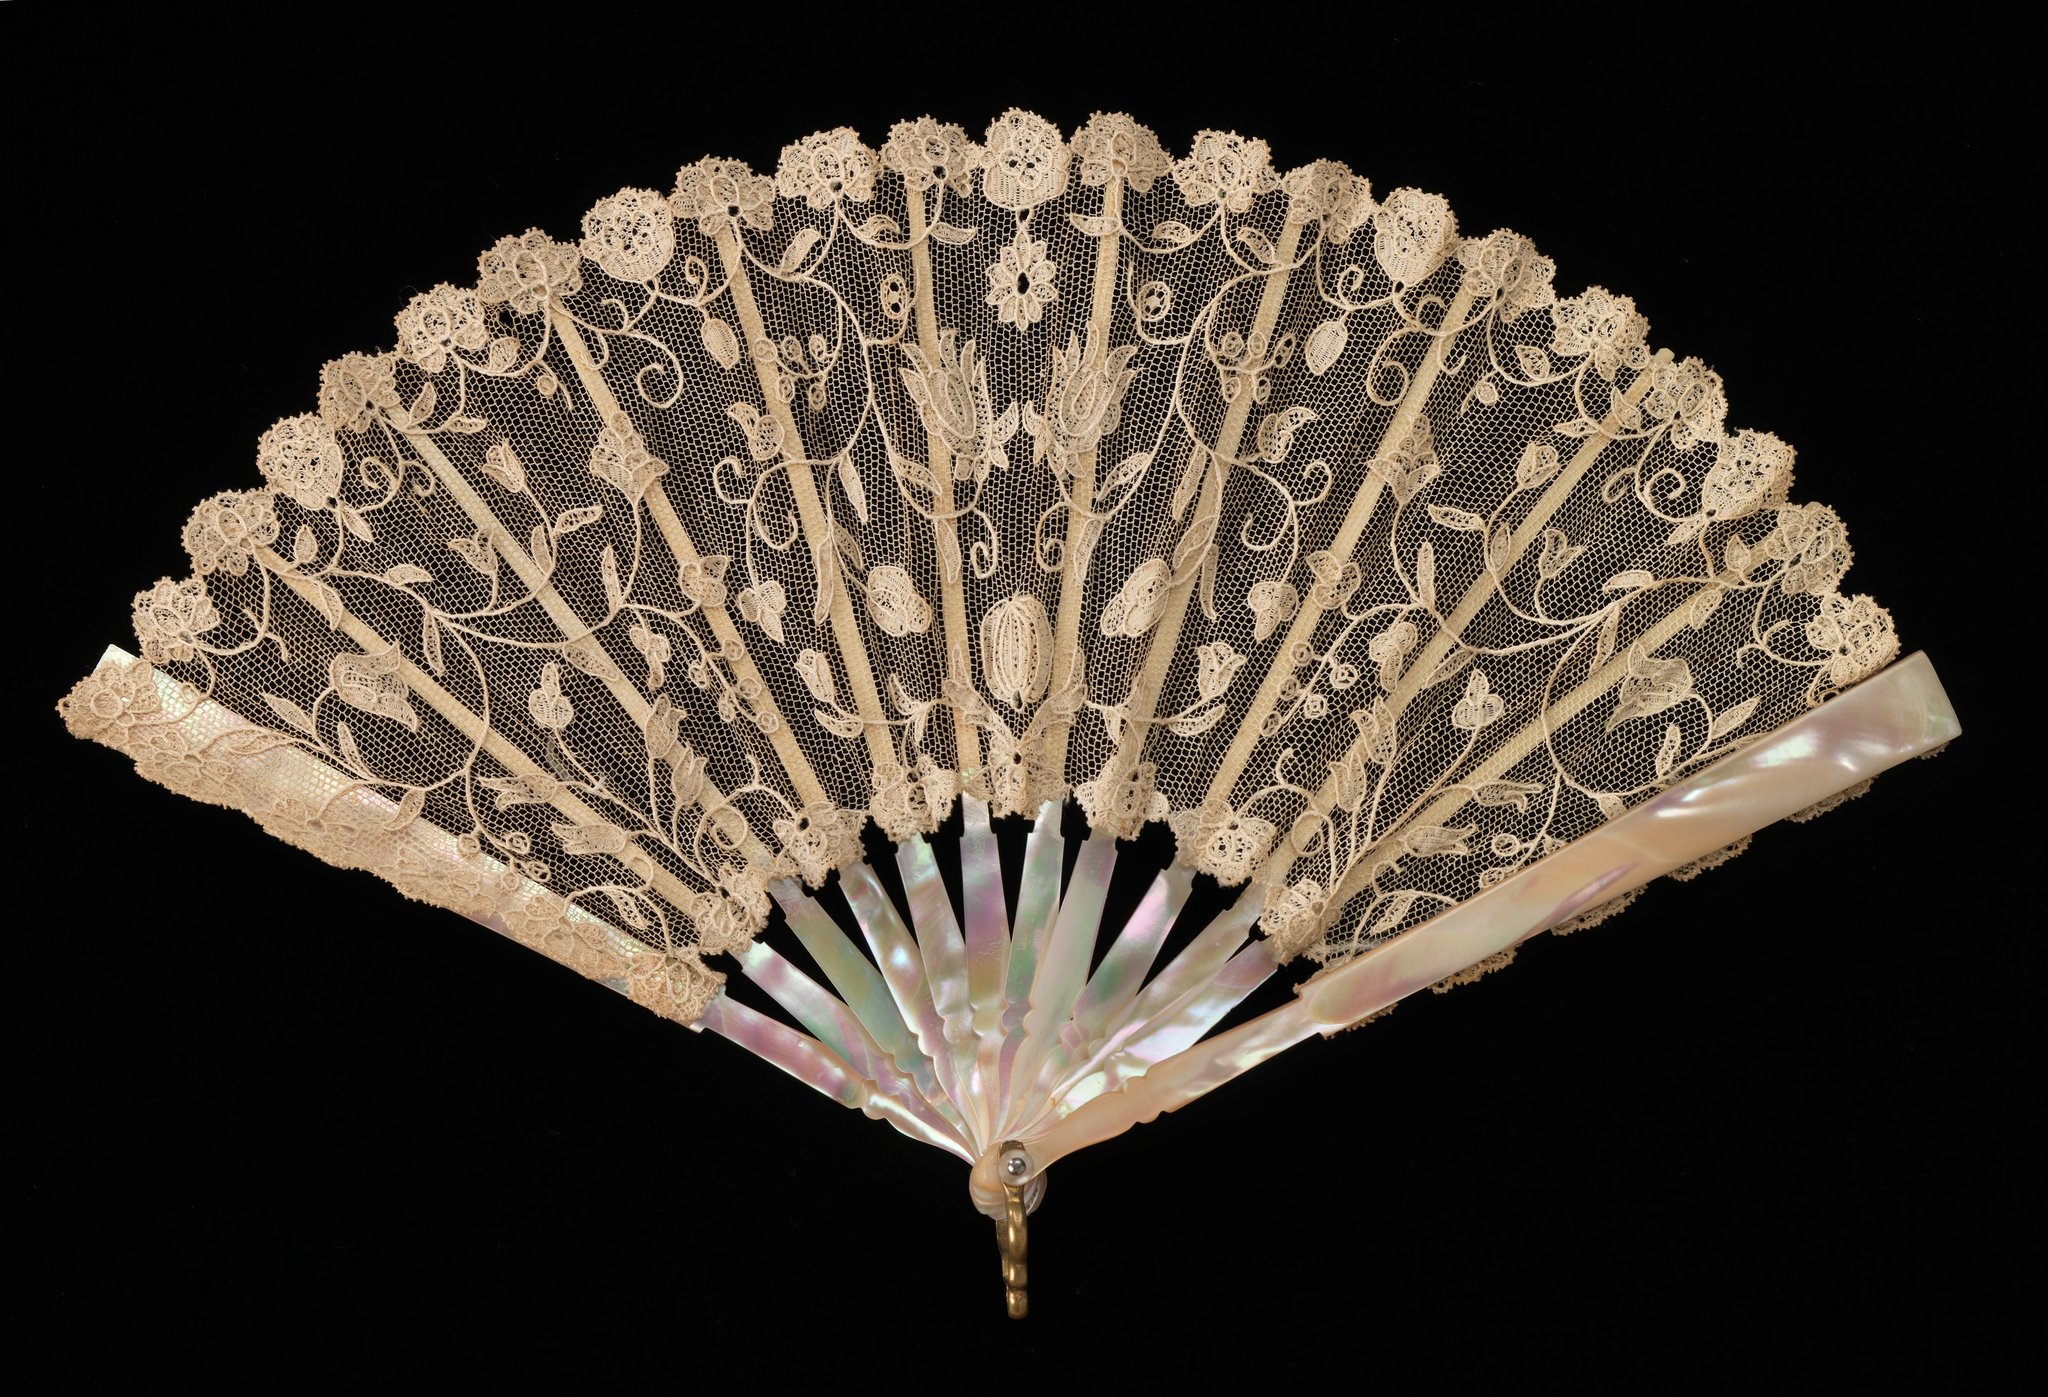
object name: fan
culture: european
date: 1876-1900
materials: bone, linen, metal, mother of pearl